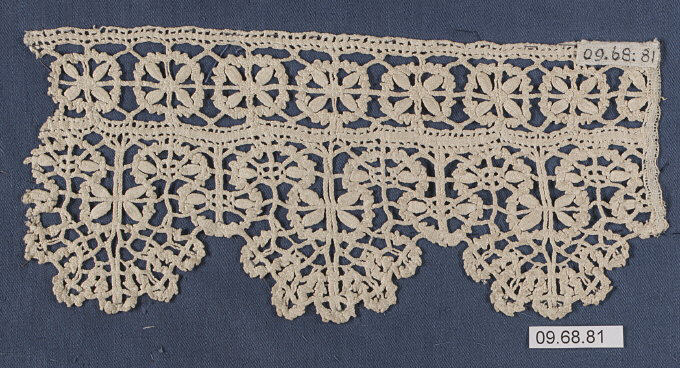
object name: piece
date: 1601-1700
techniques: lace